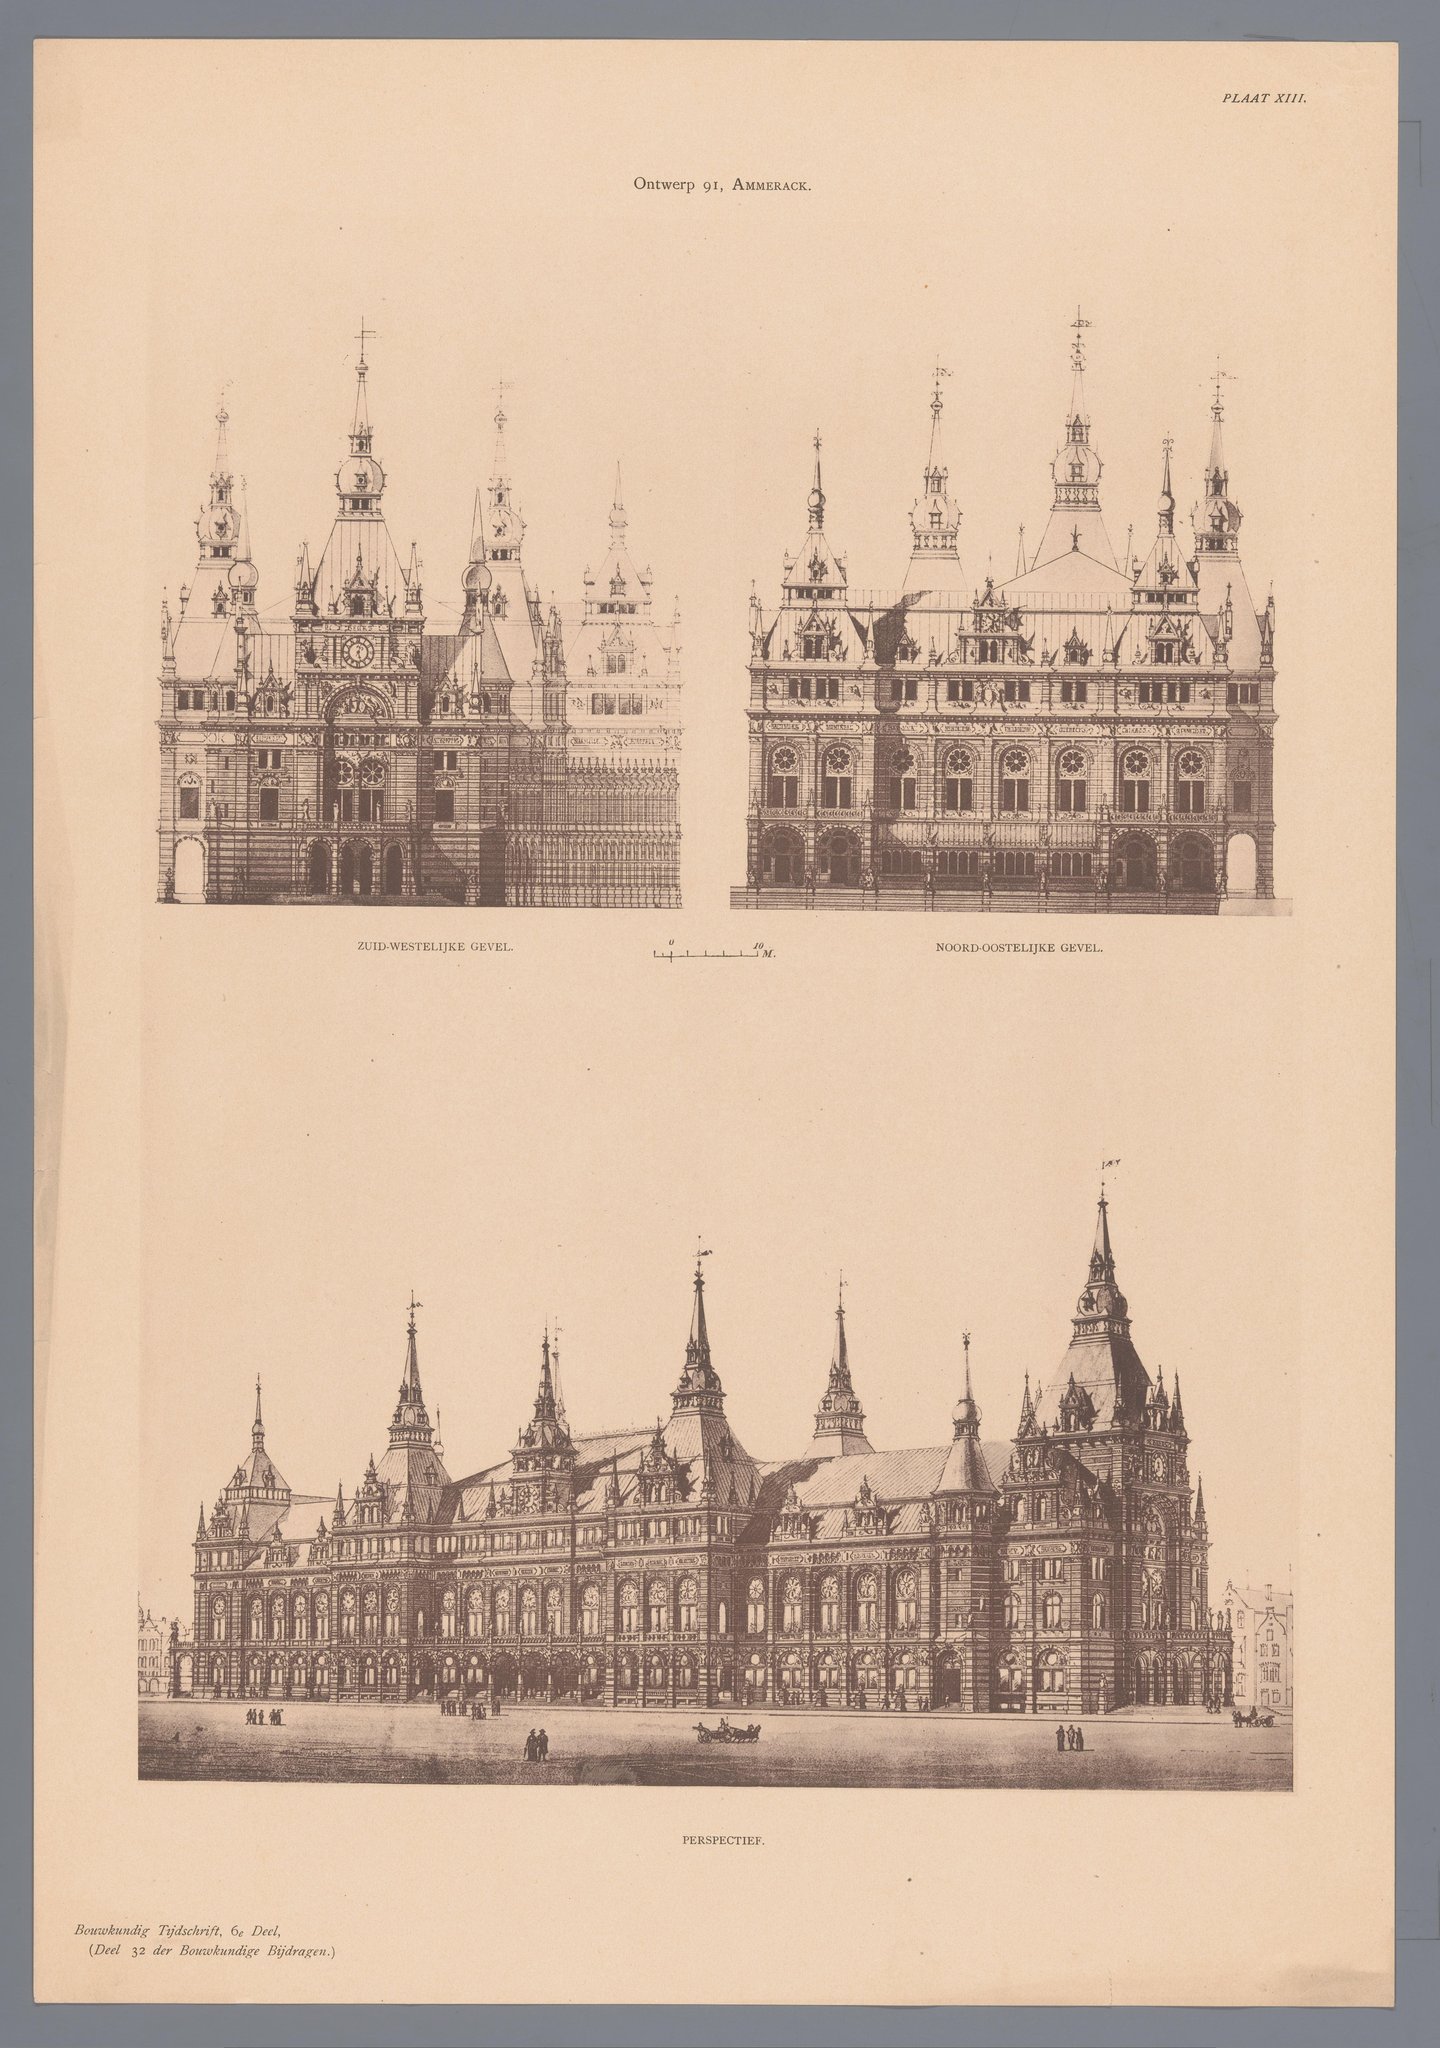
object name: book illustration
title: Ontwerp voor een nieuw beursgebouw in Amsterdam: drie aangezichten van de gevel van ontwerp 91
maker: Anonymous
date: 1886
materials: paper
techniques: photograph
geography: amsterdam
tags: market-hall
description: Prent uit: Bouwkundig tijdschrift 6, deel 32 der bouwkundige bijdragen (1886), pl. 13.